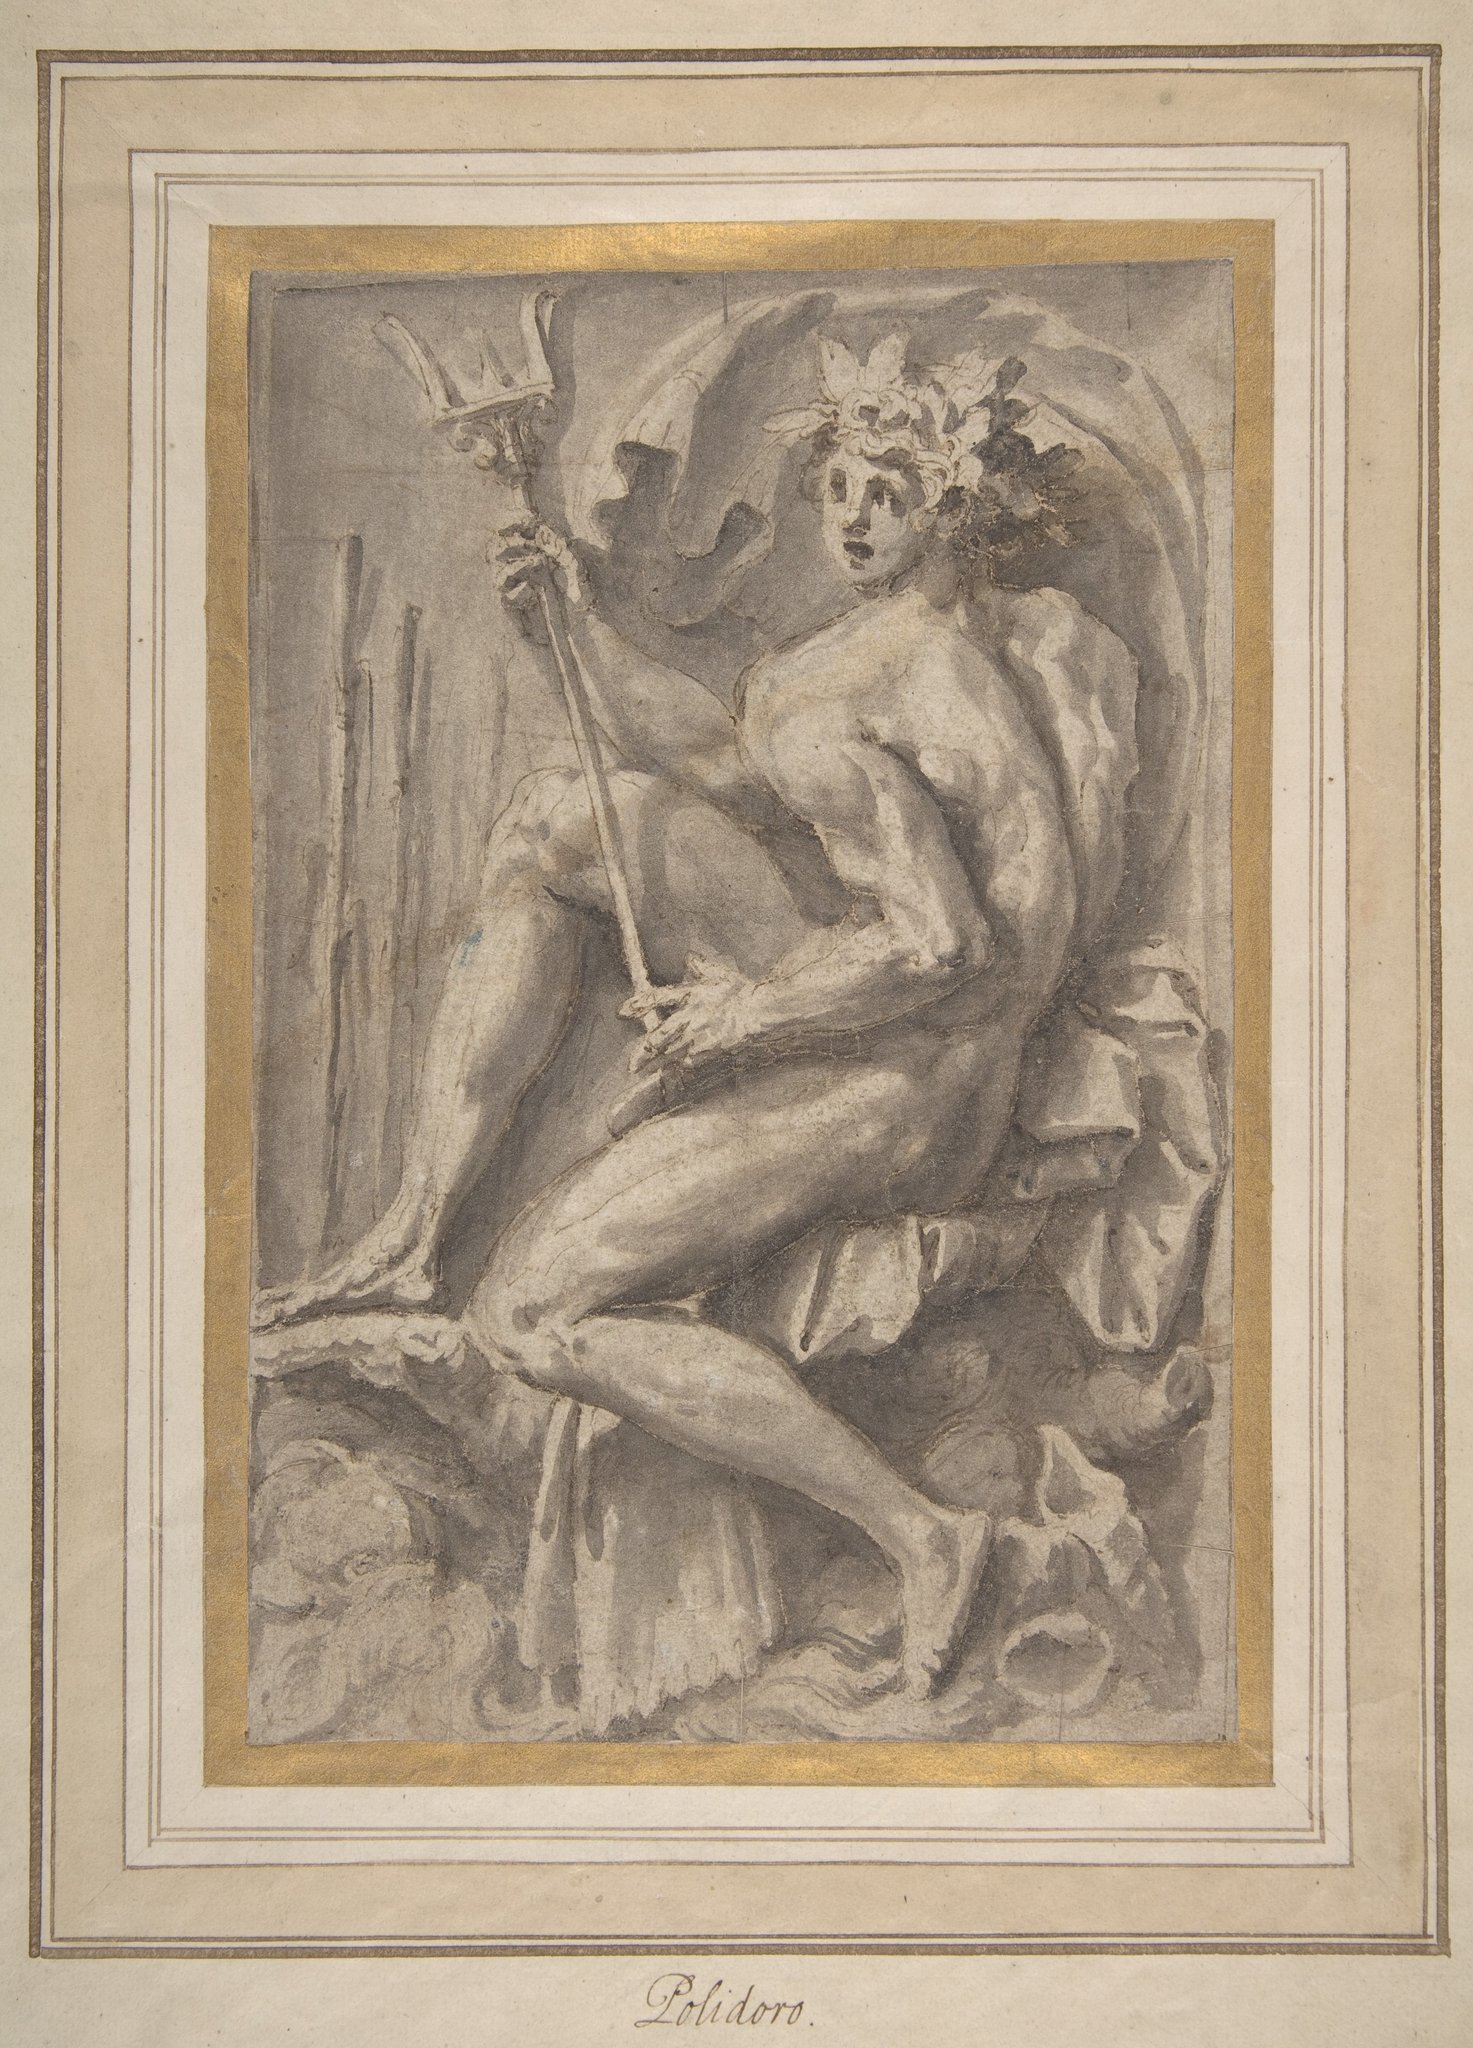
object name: drawing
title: Seated Triton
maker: perino del vaga (pietro buonaccorsi)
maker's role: artist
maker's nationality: italian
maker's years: 1501-1547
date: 1545-1547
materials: chalk, ink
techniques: brush, incising, pen, wash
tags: triton